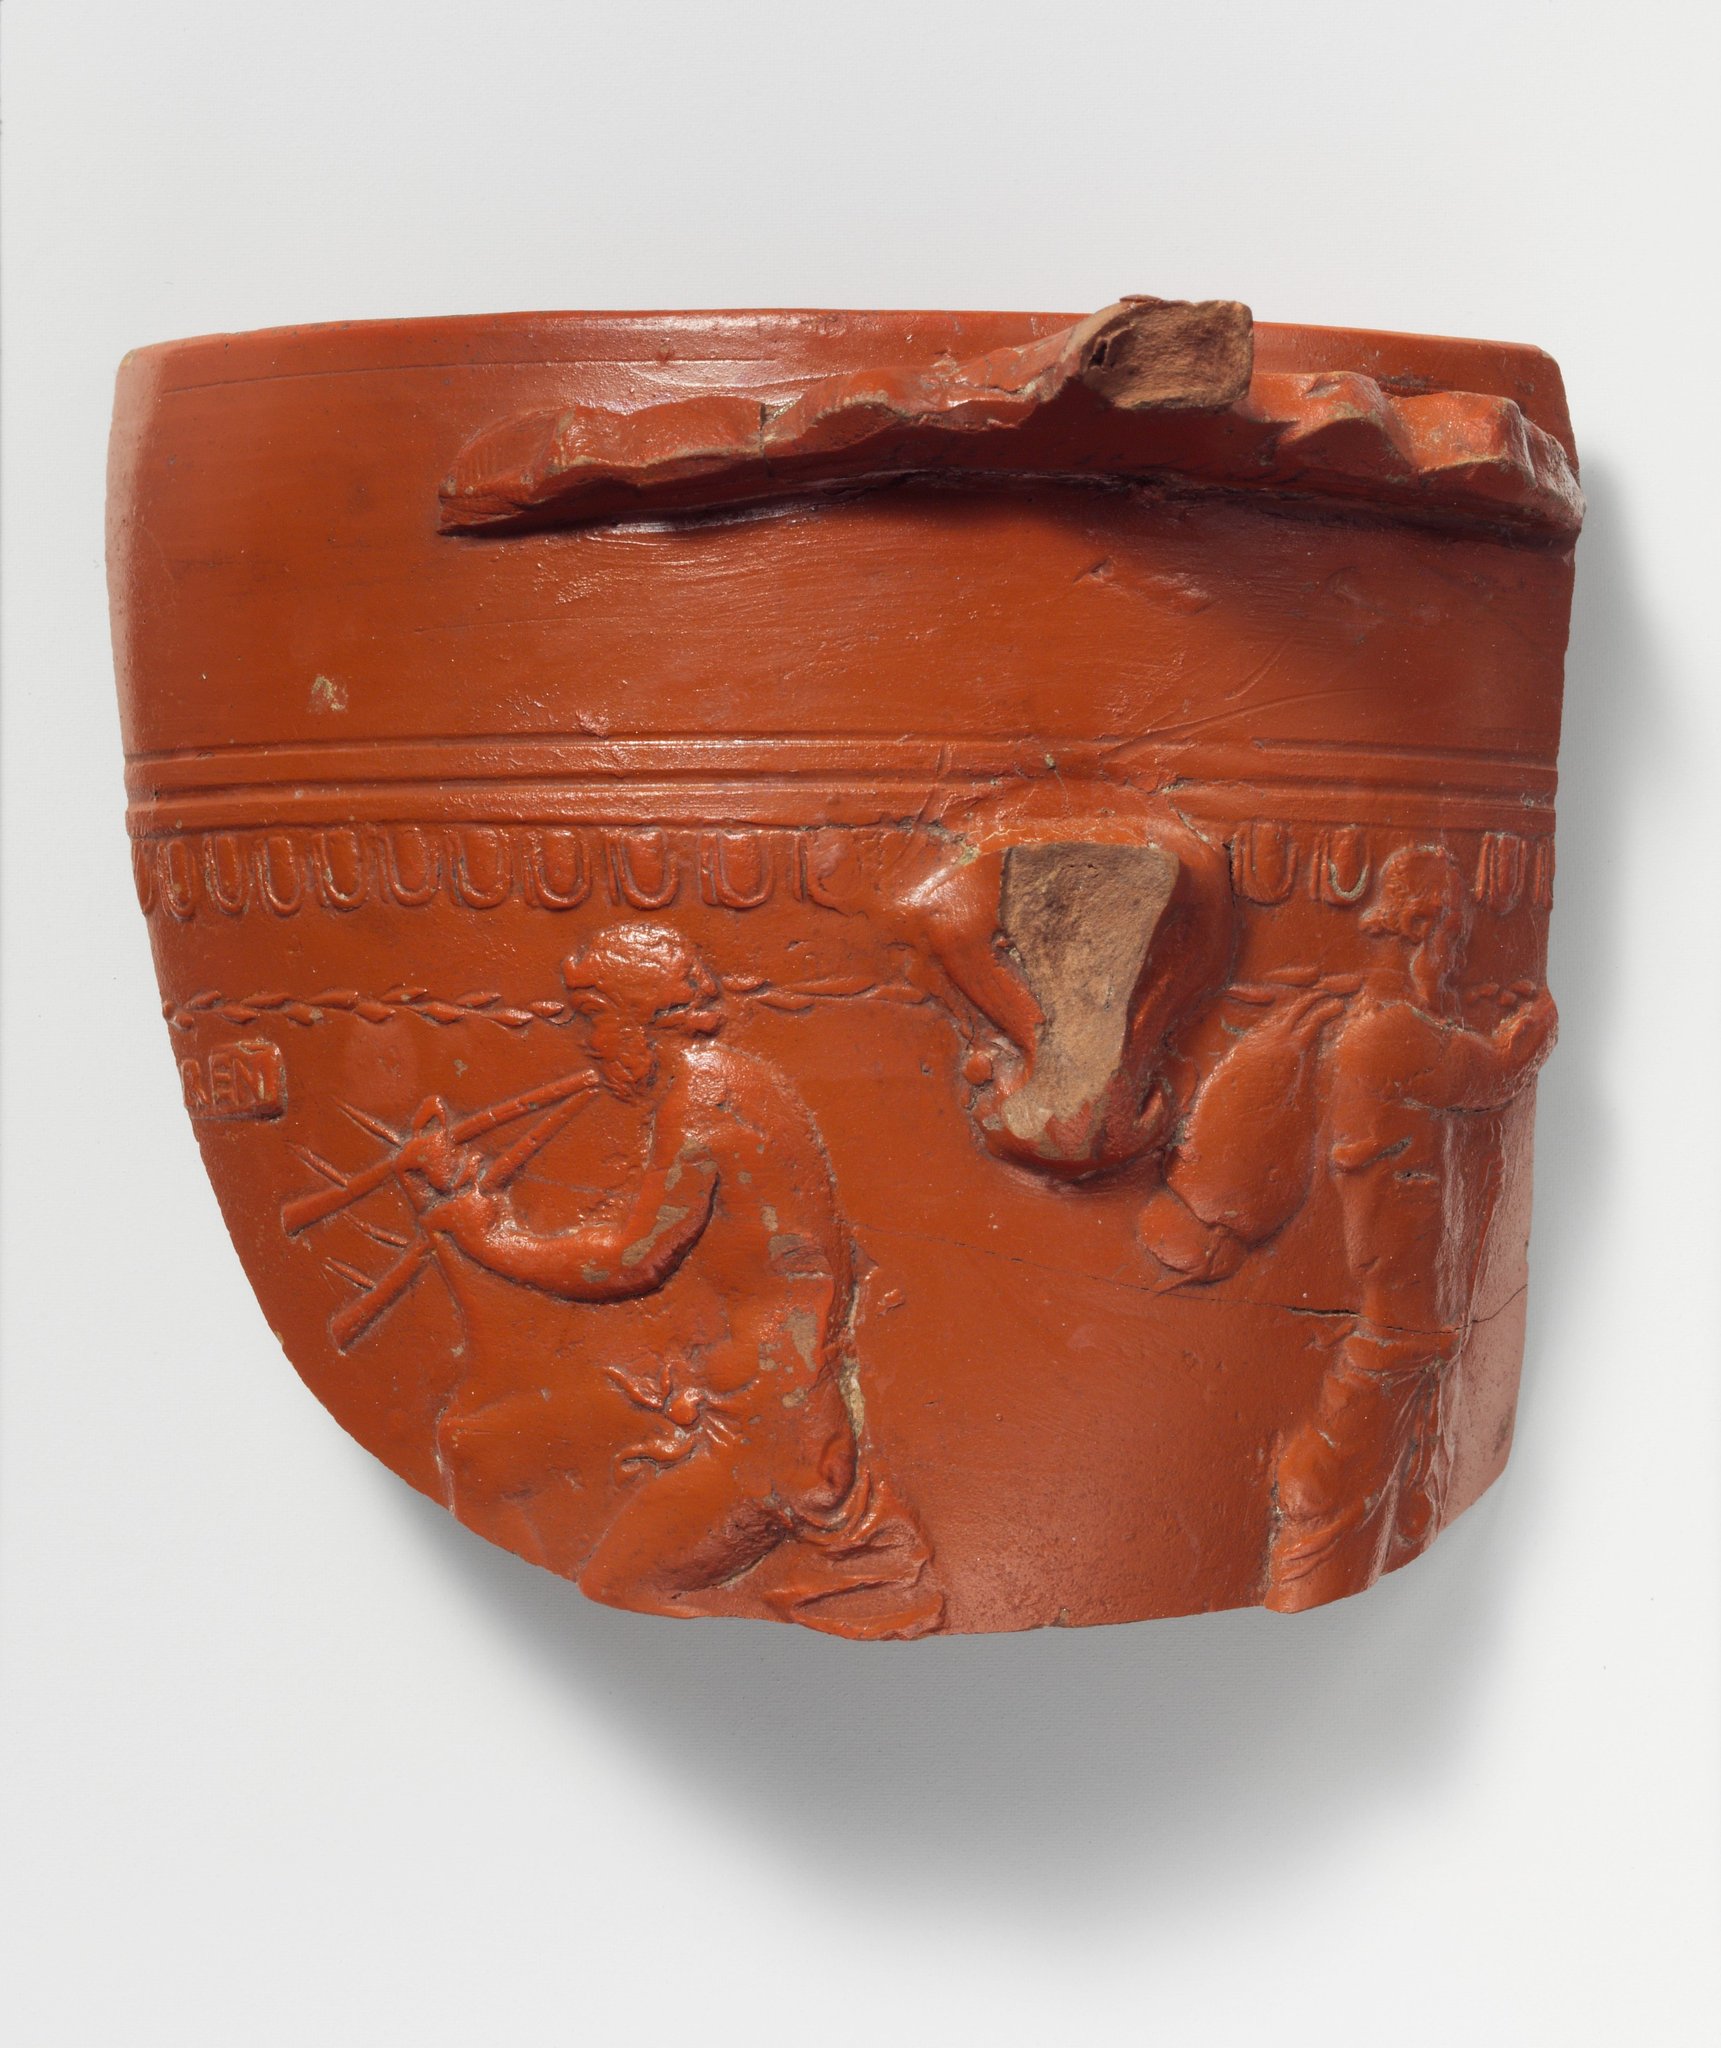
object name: cup, fragment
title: Terracotta fragment of an Arretine cup with satyrs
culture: roman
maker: perennius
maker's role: artist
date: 31 BCE-14 CE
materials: terracotta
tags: musical instruments,satyrs